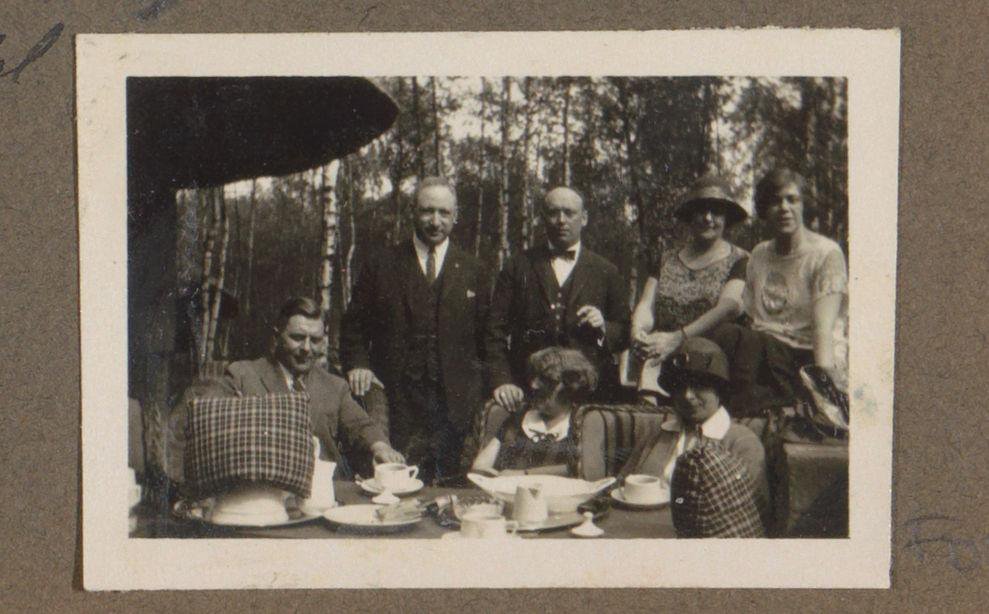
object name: photograph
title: Gezelschap aan de thee in het Kievitsdal, tussen Baarn en Hilversum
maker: Anonymous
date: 1905-1924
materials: photographic support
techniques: gelatin silver print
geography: netherlands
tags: eating and drinking, netherlands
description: Gezelschap aan de thee op het terras van restaurant Groot Kievitsdal aan de Hilversumsestraatweg 19 in Baarn. Onderdeel van fotoalbum van een onbekende Nederlandse familie met opnames van Suriname, Europa en Nederlands-Indië.